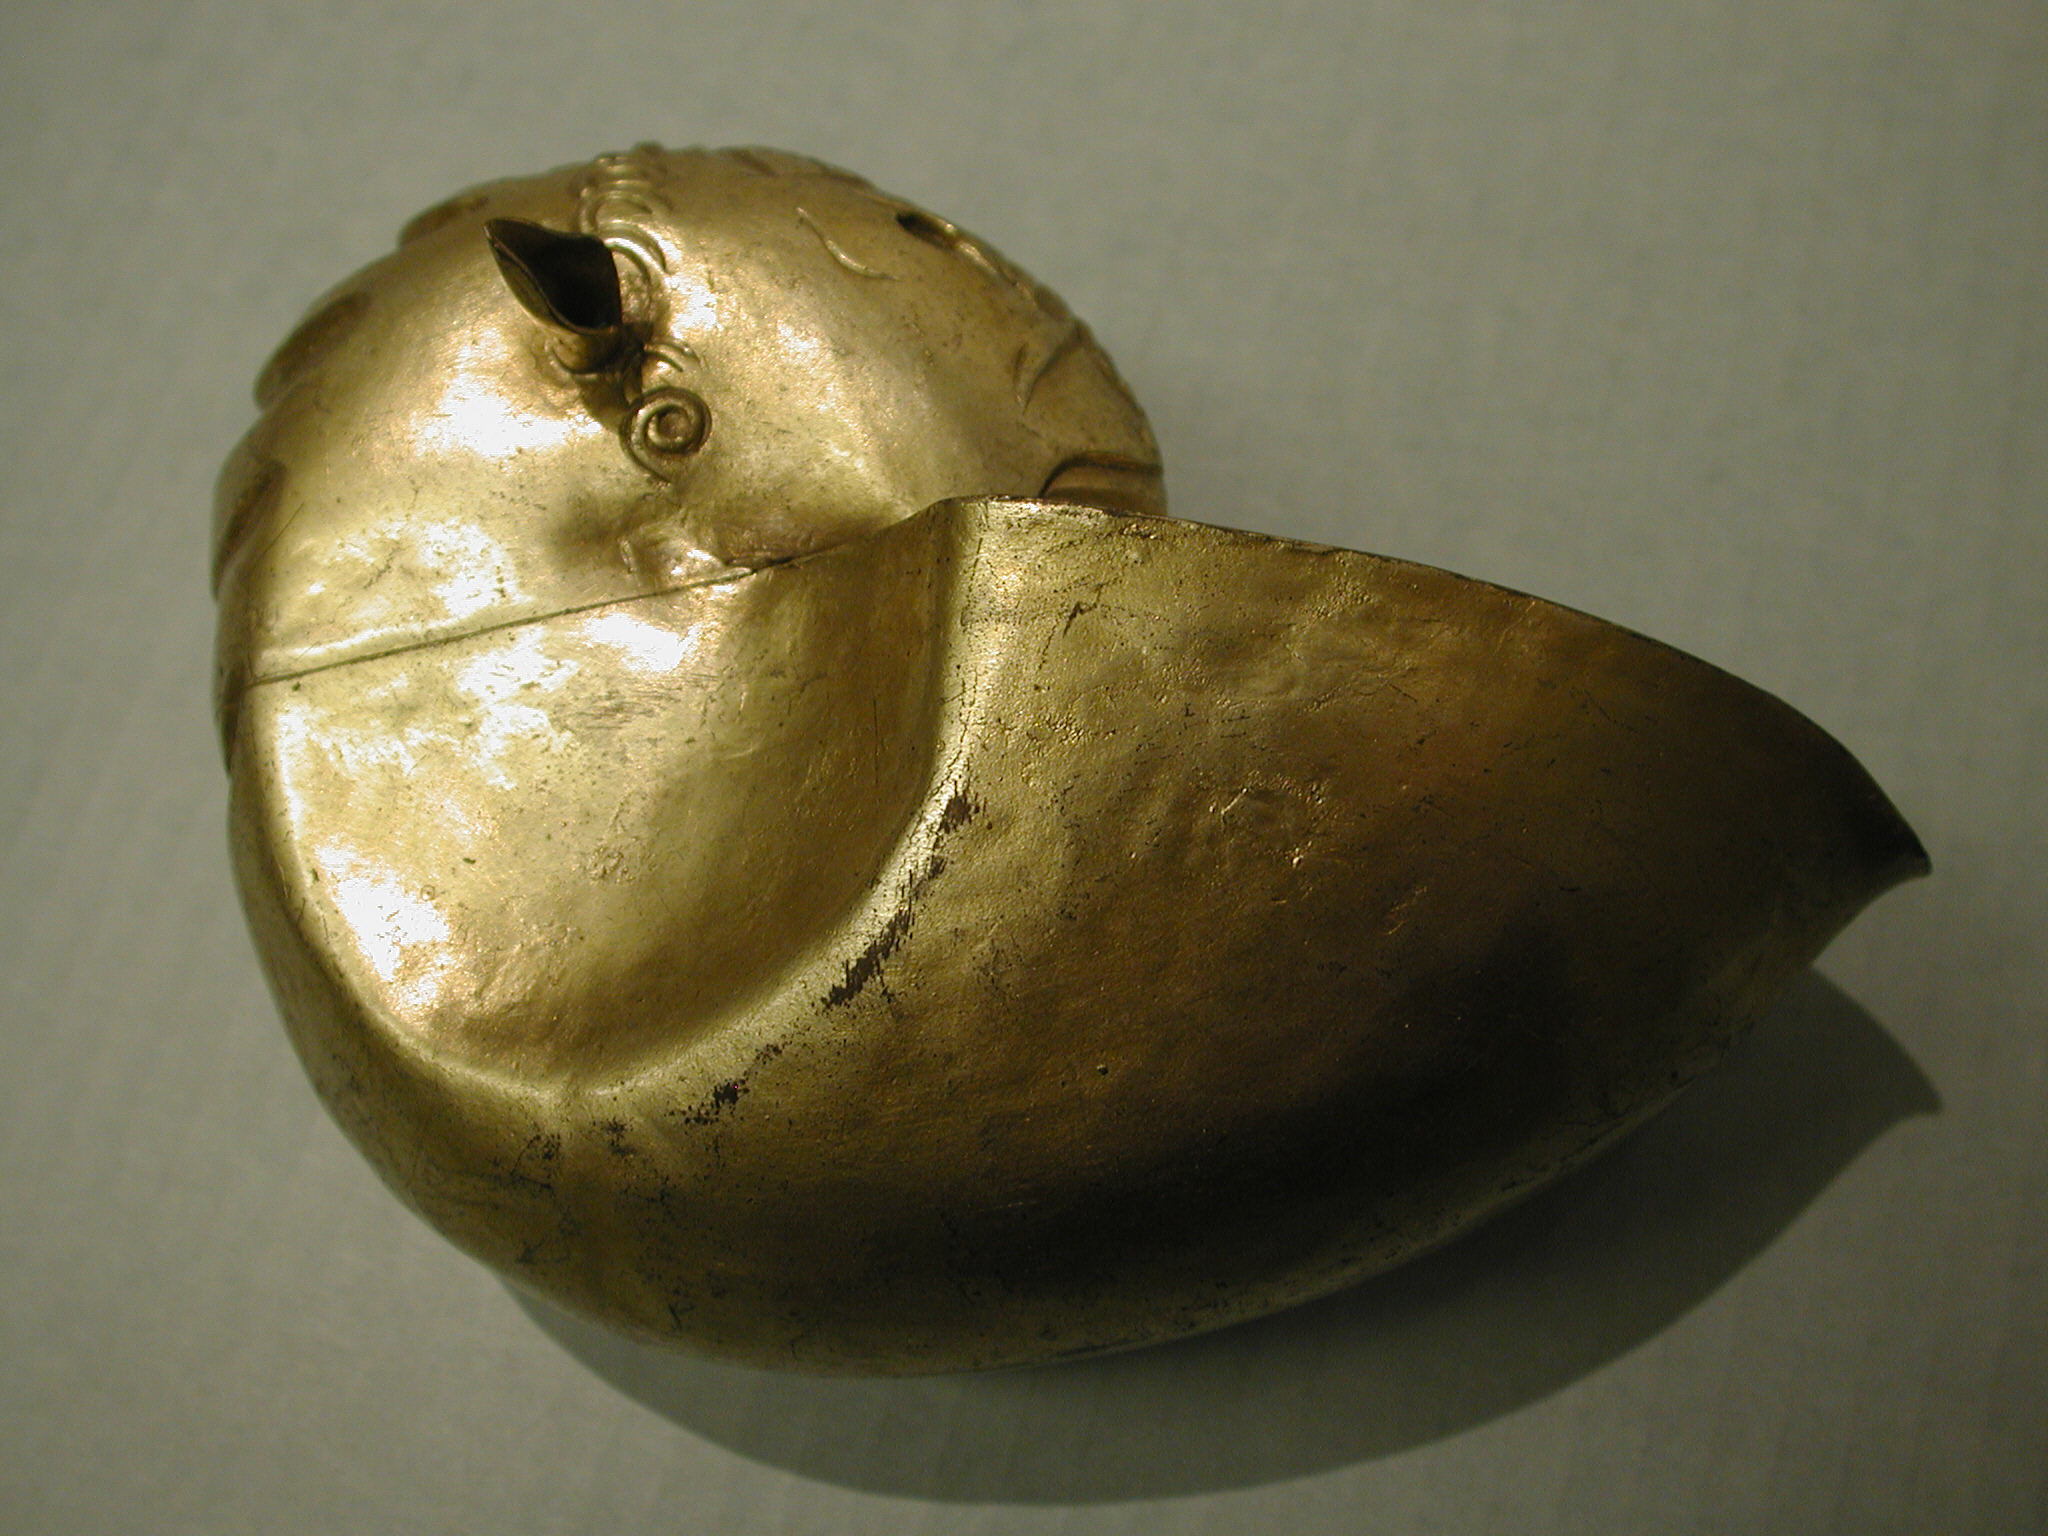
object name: cup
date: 1801-1900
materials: metal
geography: hungary